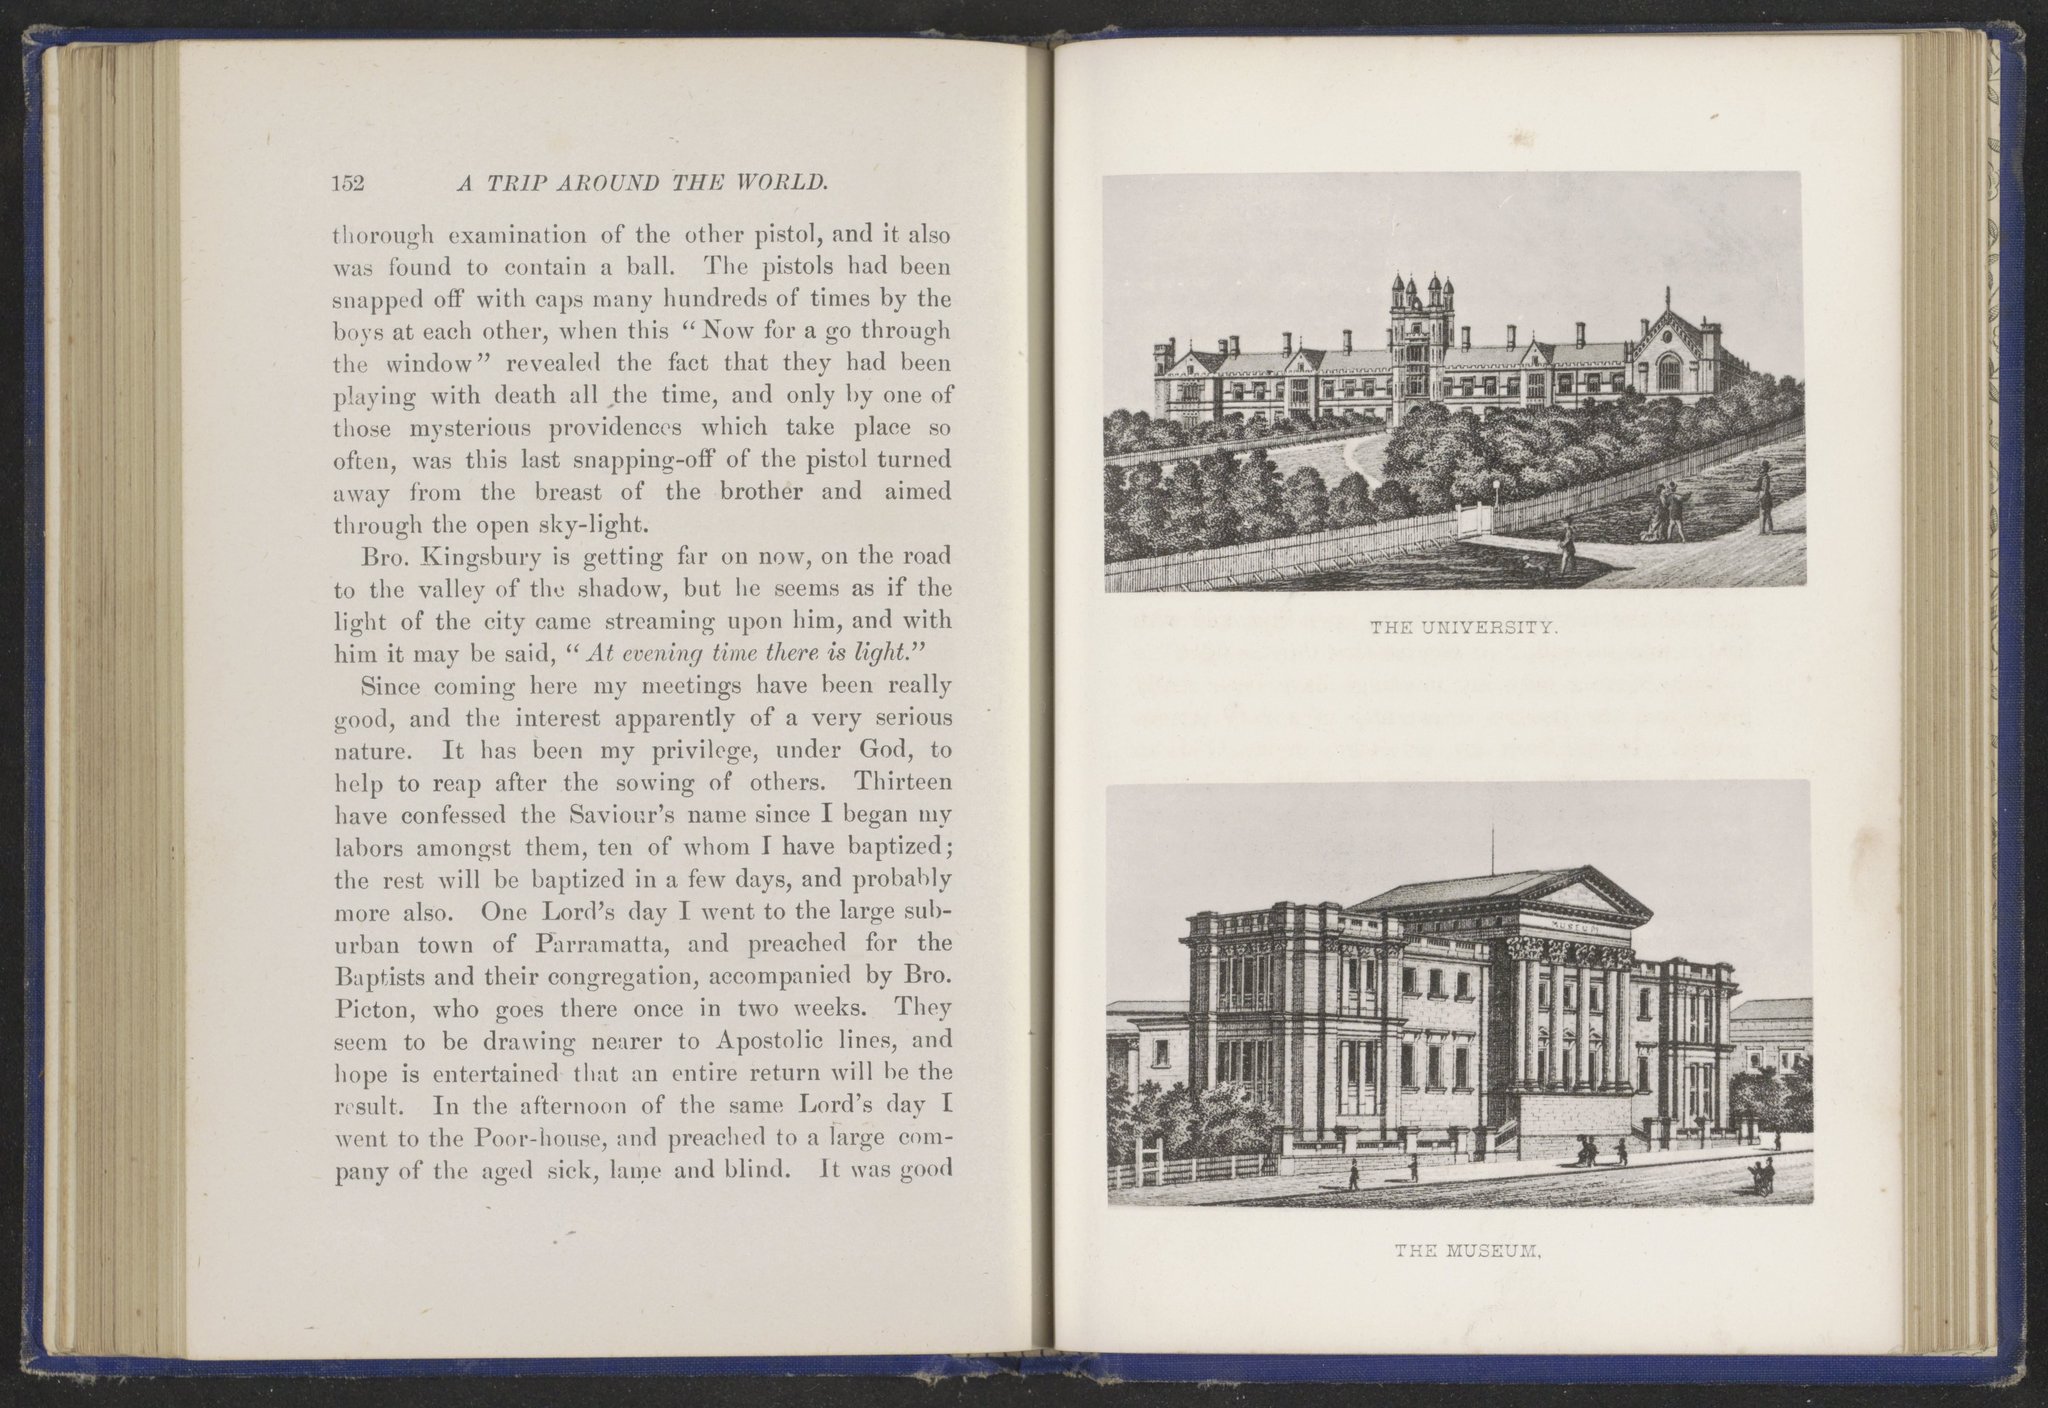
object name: photomechanical print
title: The university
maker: Anonymous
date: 1870-1882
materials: paper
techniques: photograph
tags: university, façade (of house or building)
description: Boven een gezicht op de universiteit van Parramatta, onder een gezicht op een museum te Parramatta.